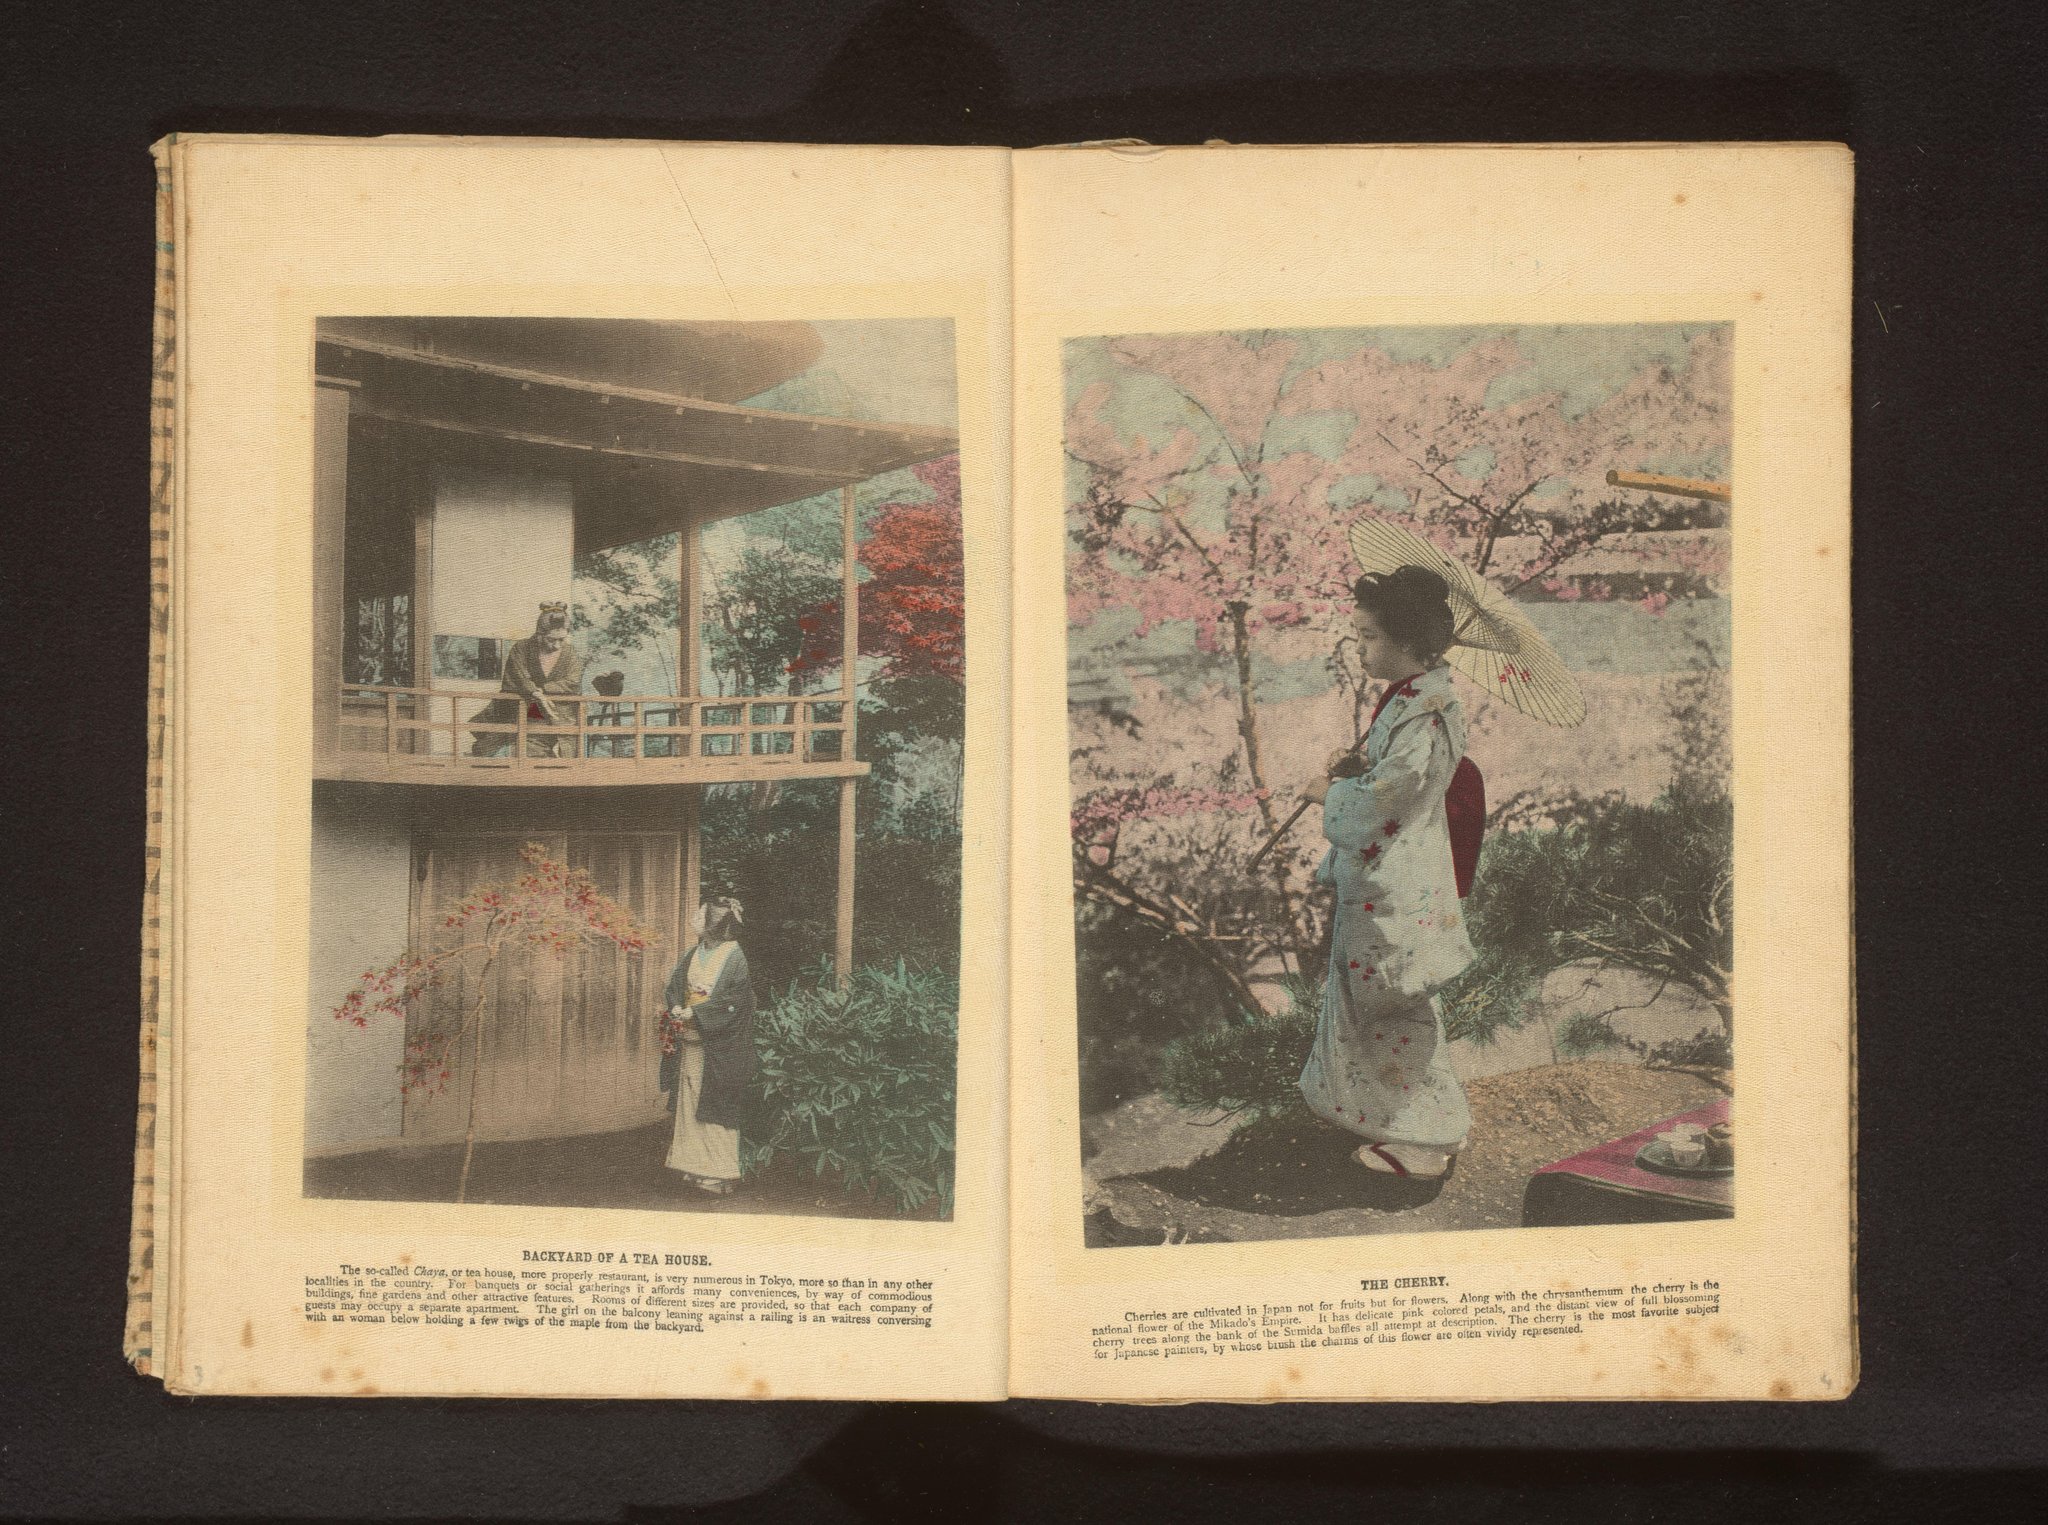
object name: page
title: The cherry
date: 1886-1896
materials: paper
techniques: photograph, hand coloring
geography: japan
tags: adult woman, trees: cherry-tree (flowers, blossom, blossoming), parasol, sunshade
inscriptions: inscription: ‘Cherries are cultivated (...) vividly represented.’